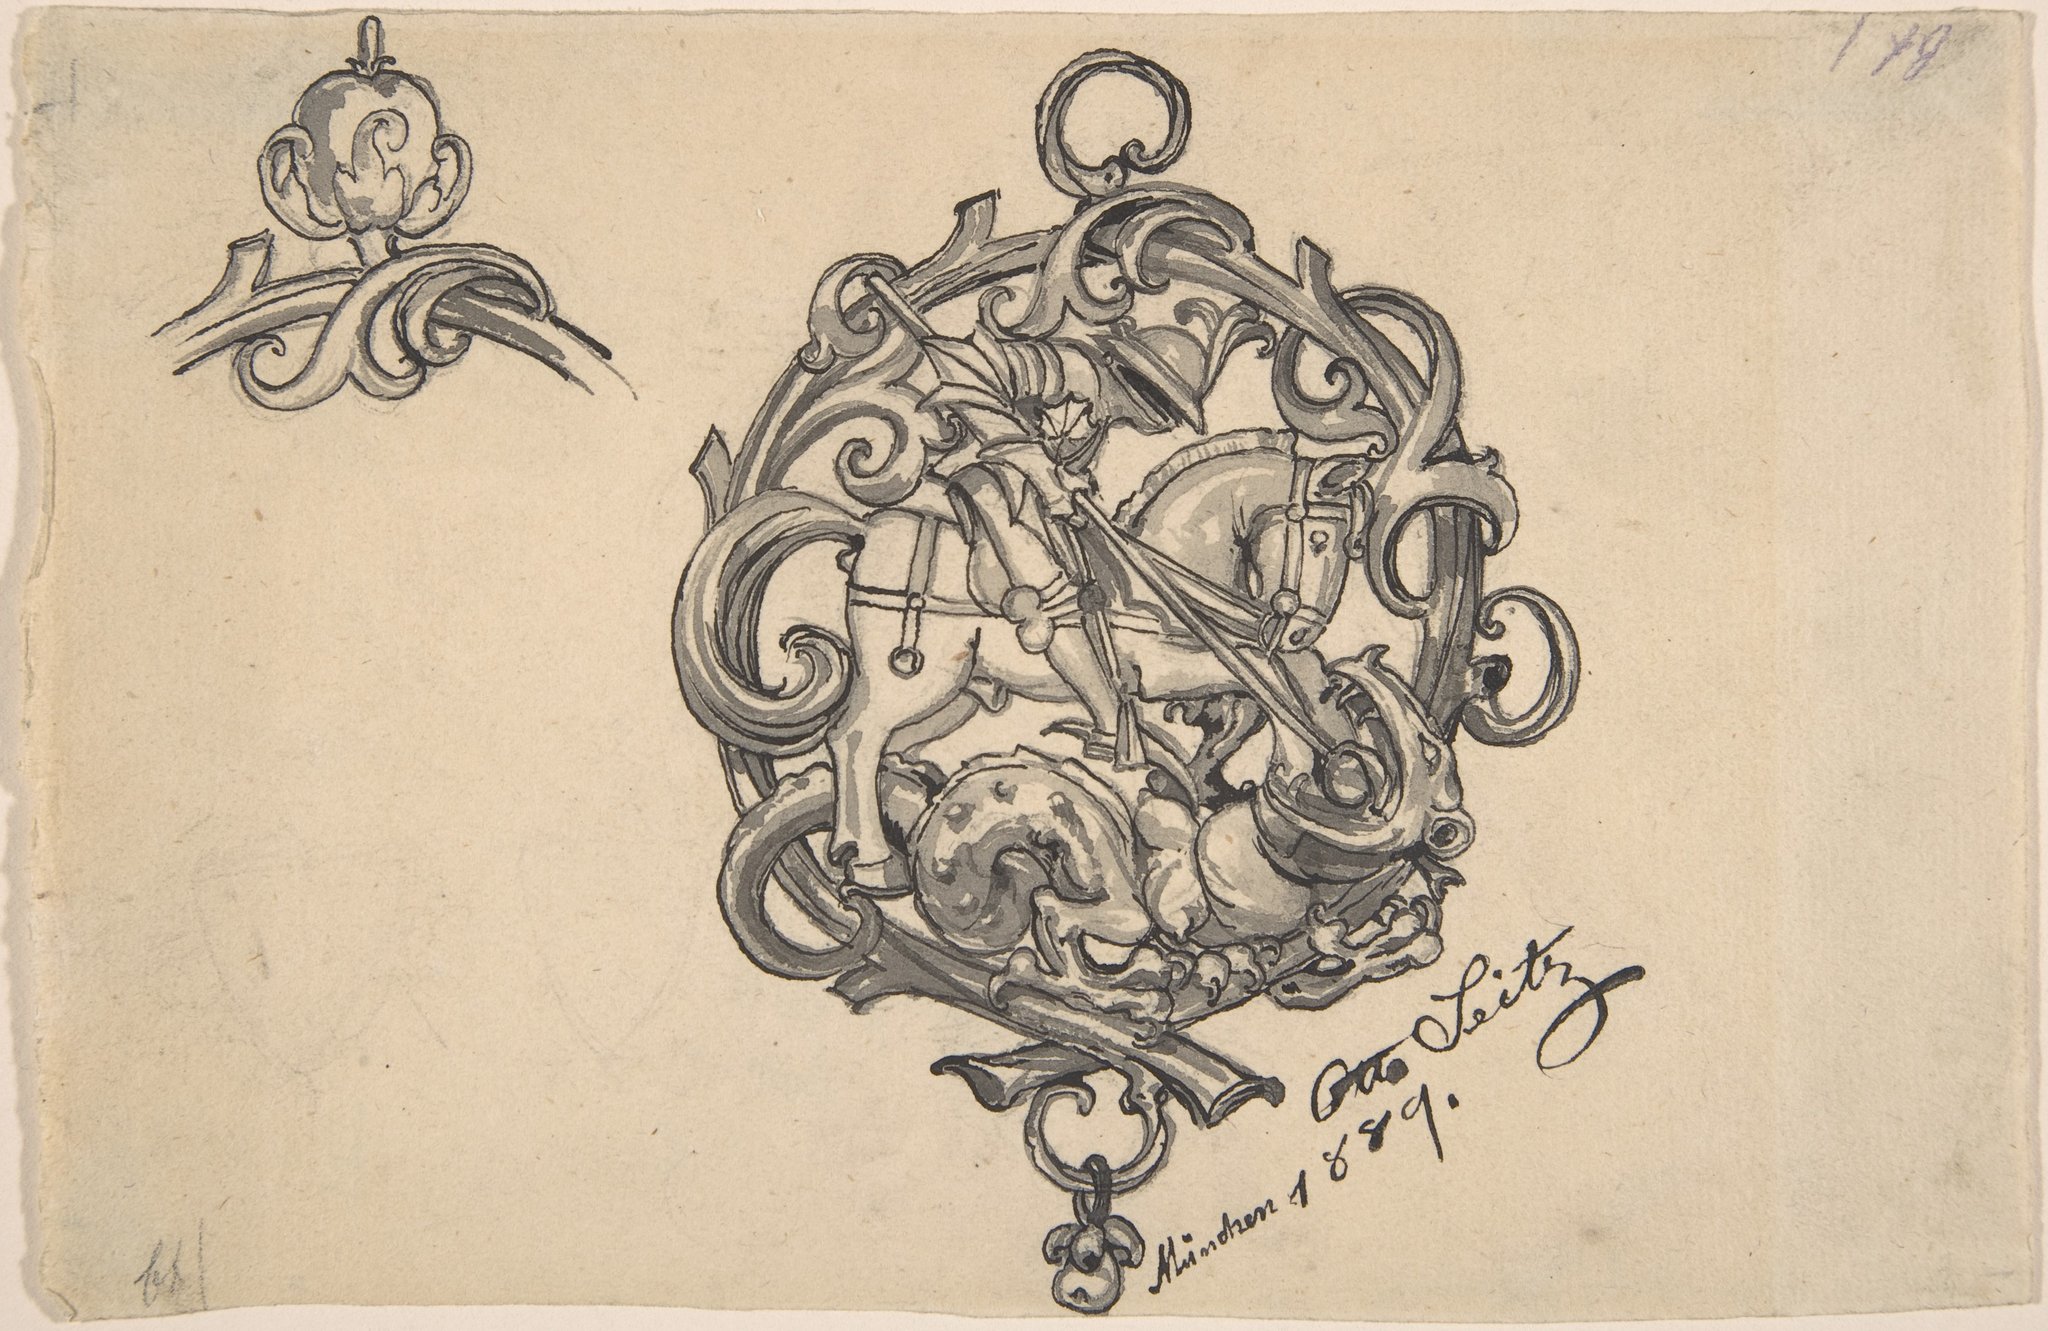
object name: drawing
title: Design for a Pendant with St. George and the Dragon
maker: otto seitz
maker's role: artist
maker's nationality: german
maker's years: 1846-1912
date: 1889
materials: ink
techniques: pen, wash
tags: pendants,horses